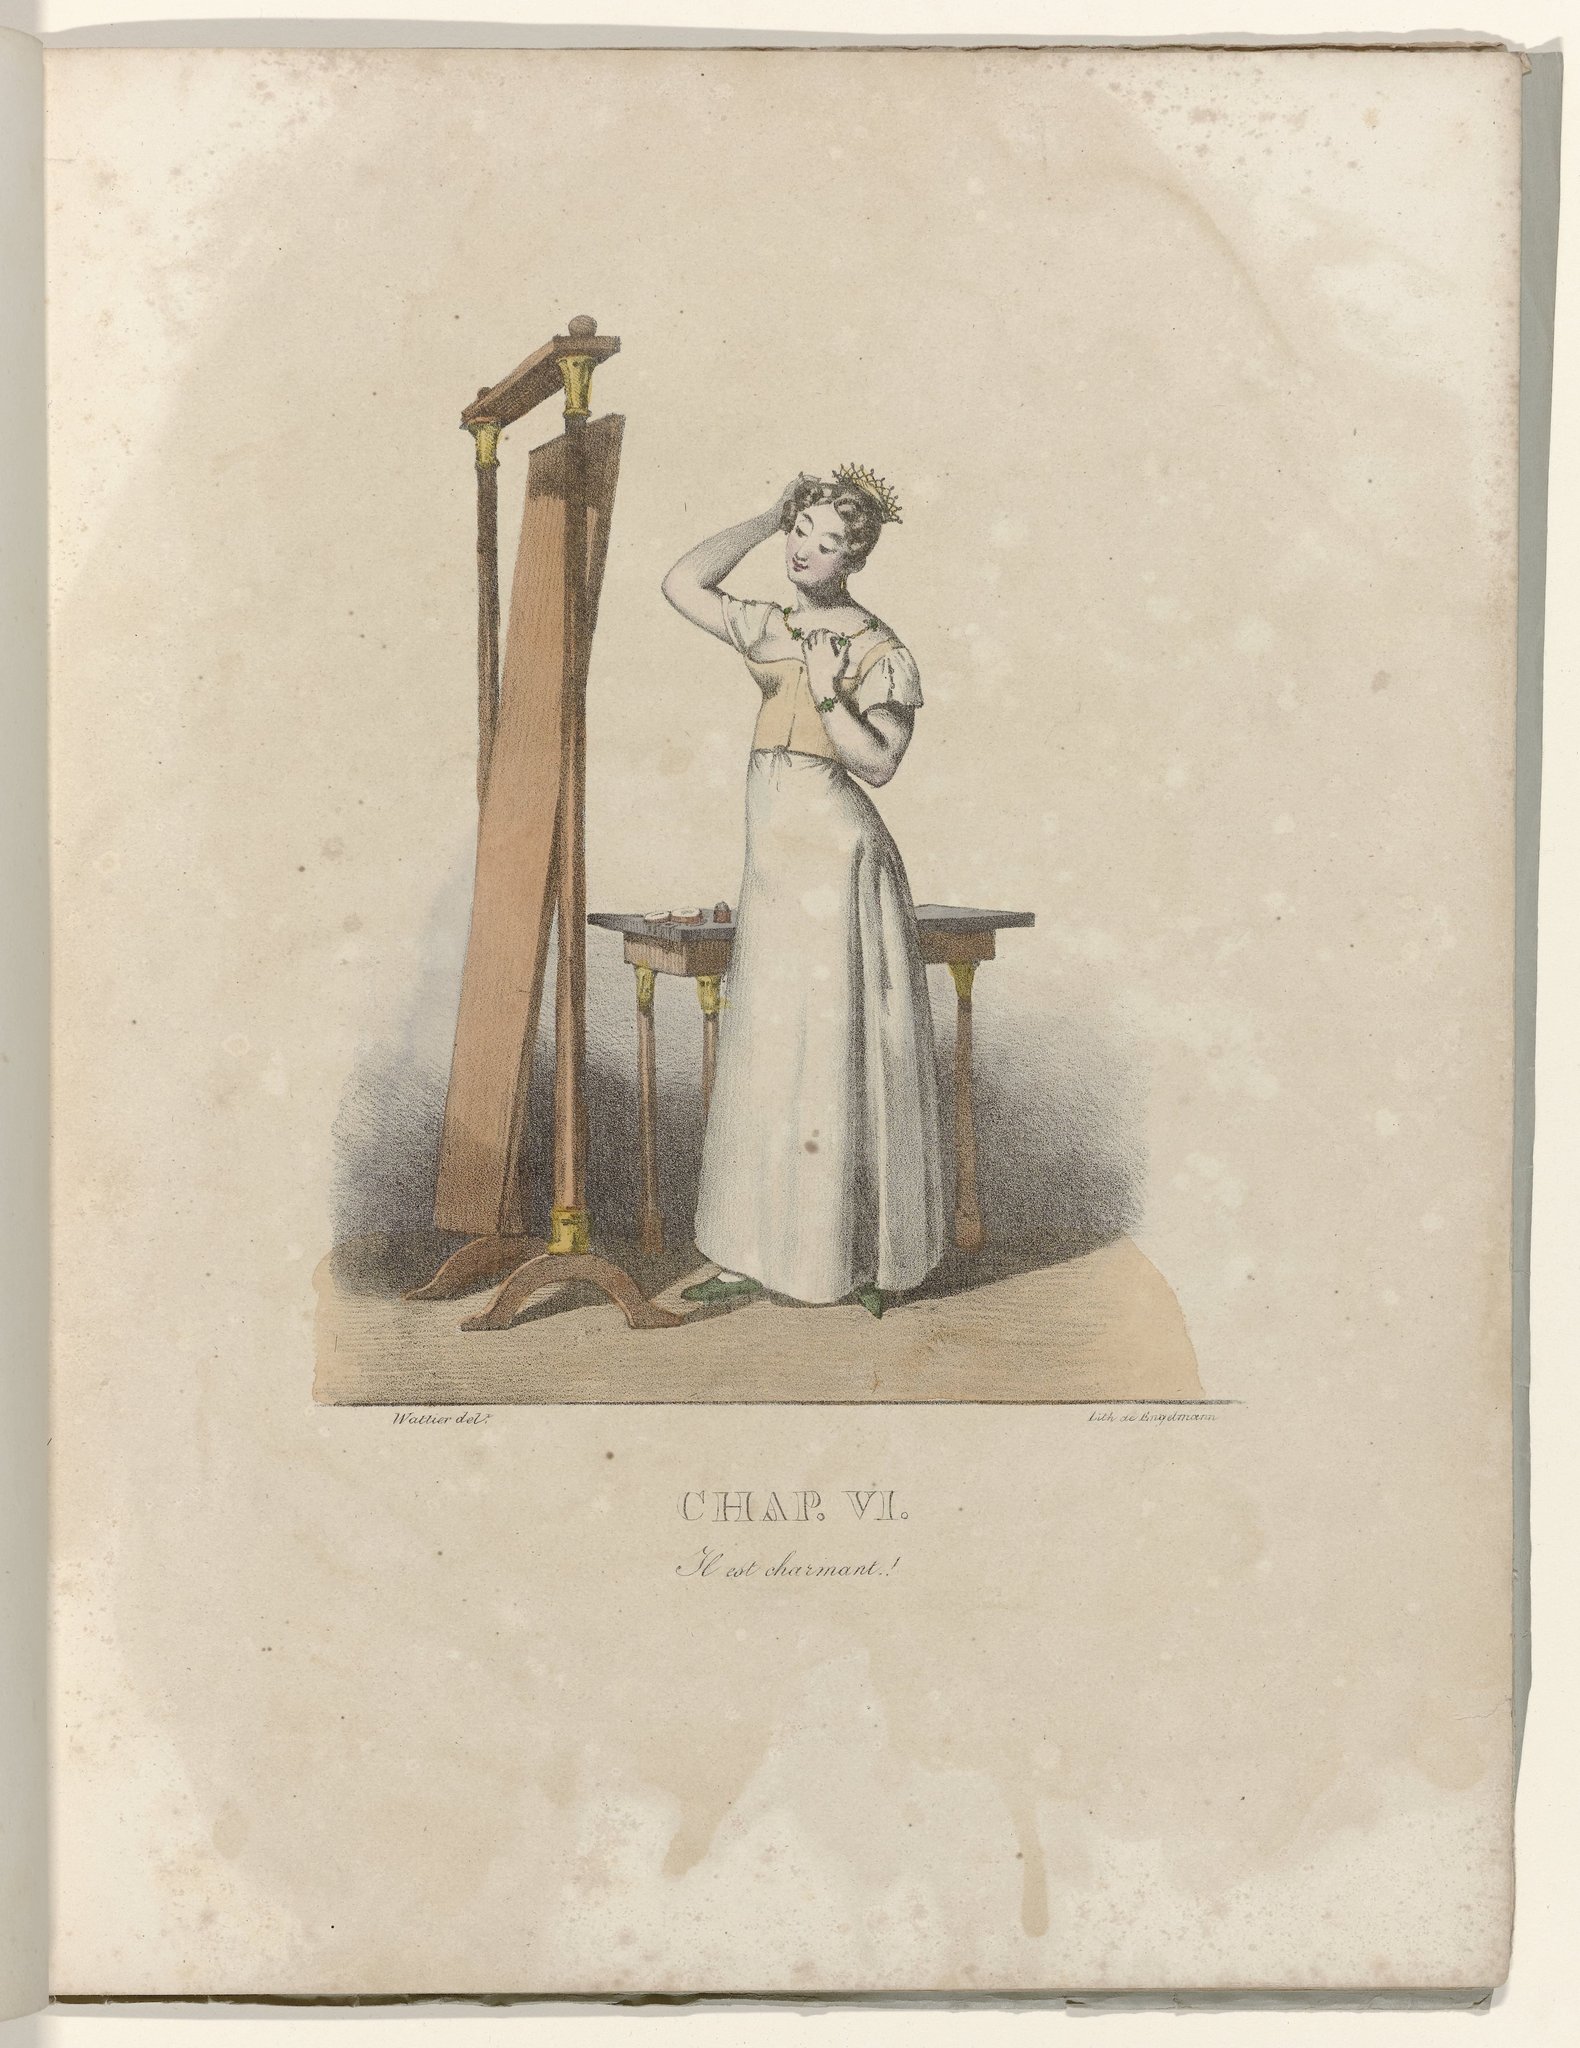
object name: fashion print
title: La Né d'une Modiste, 1828 : Chap. VI: Il est charmant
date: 1828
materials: paper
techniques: hand coloring, lithograph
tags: fashion plates